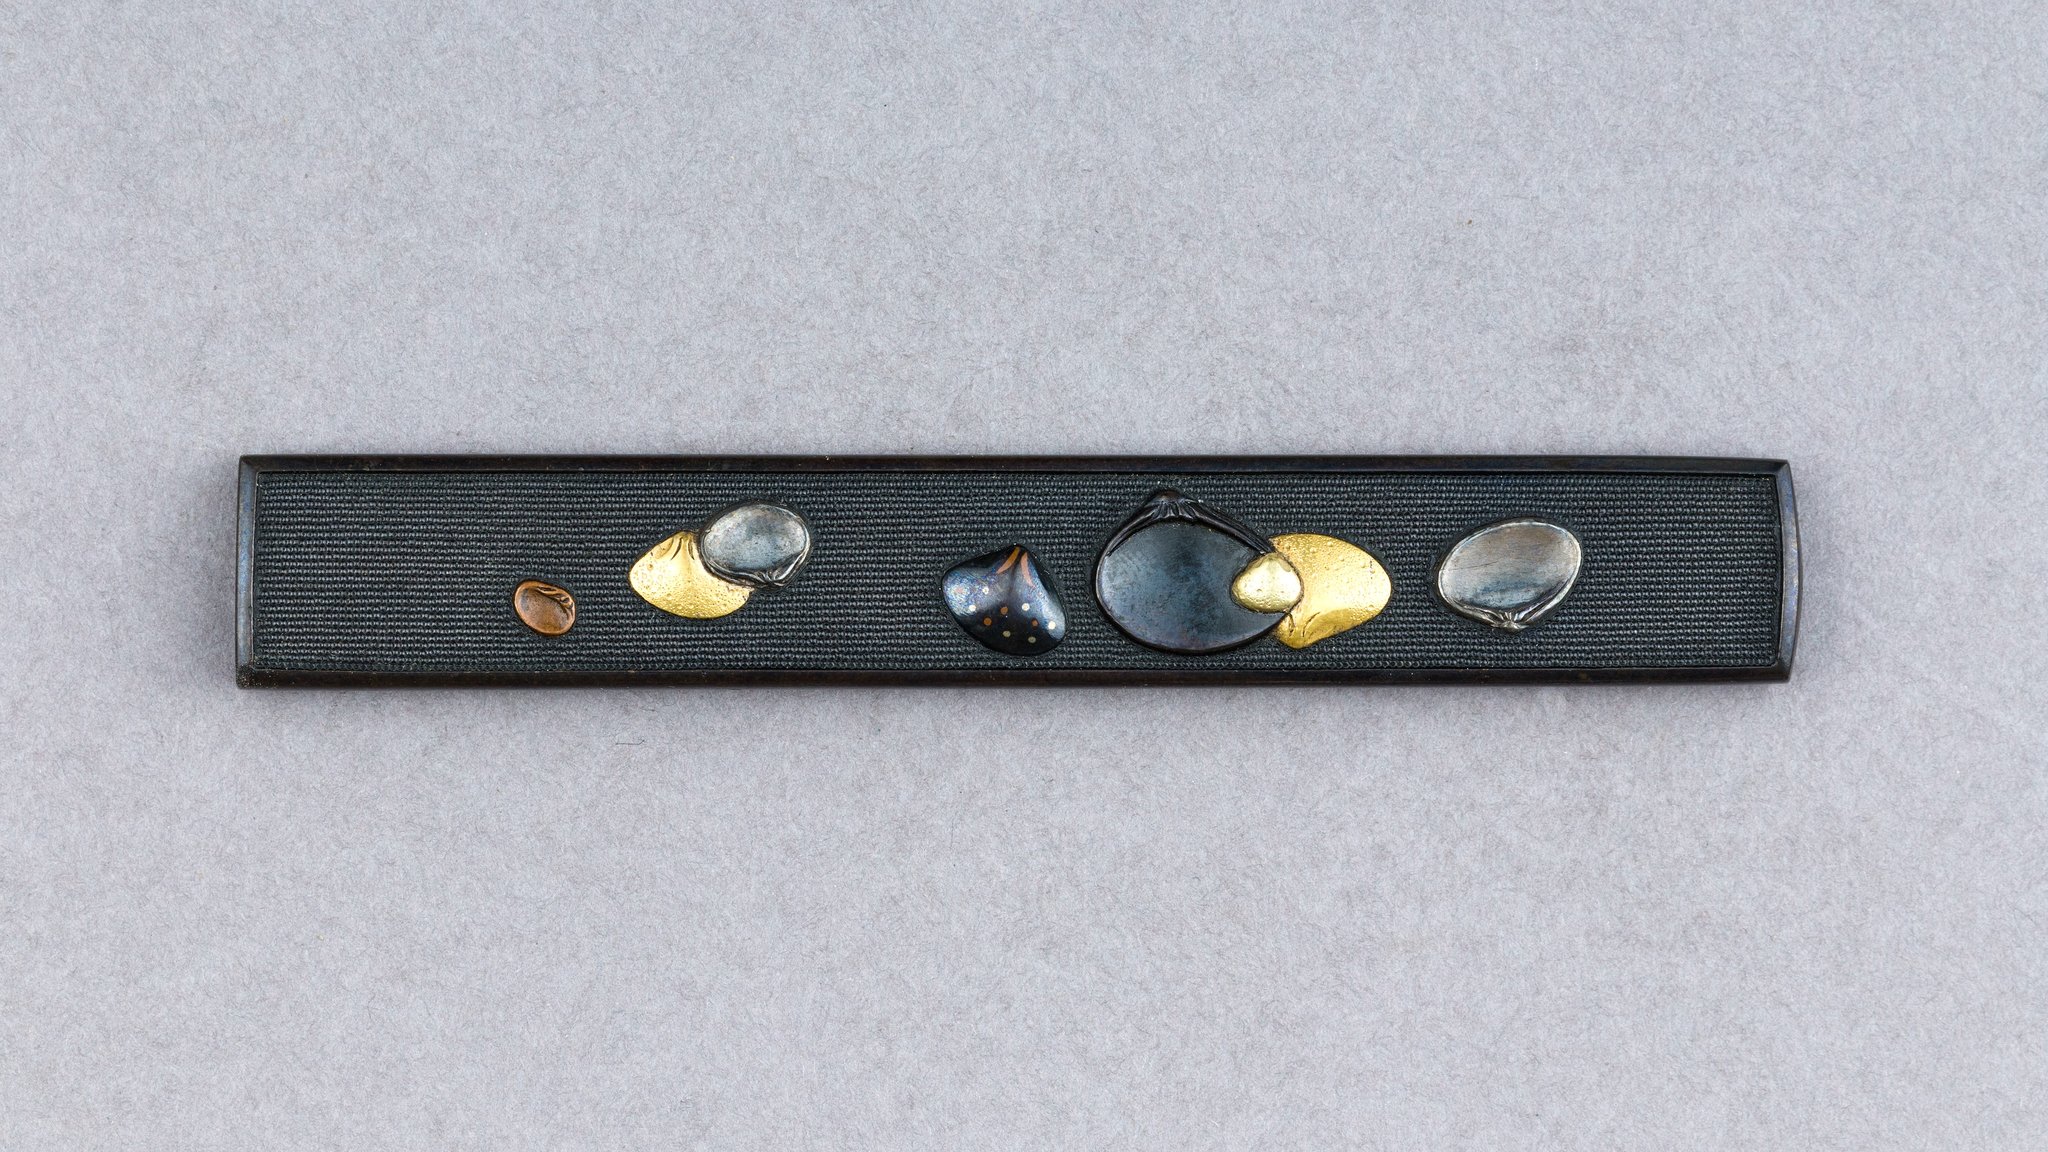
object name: knife handle kozuka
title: Knife Handle (Kozuka)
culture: japanese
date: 1615-1868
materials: copper, gold alloy, gold, silver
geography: japan